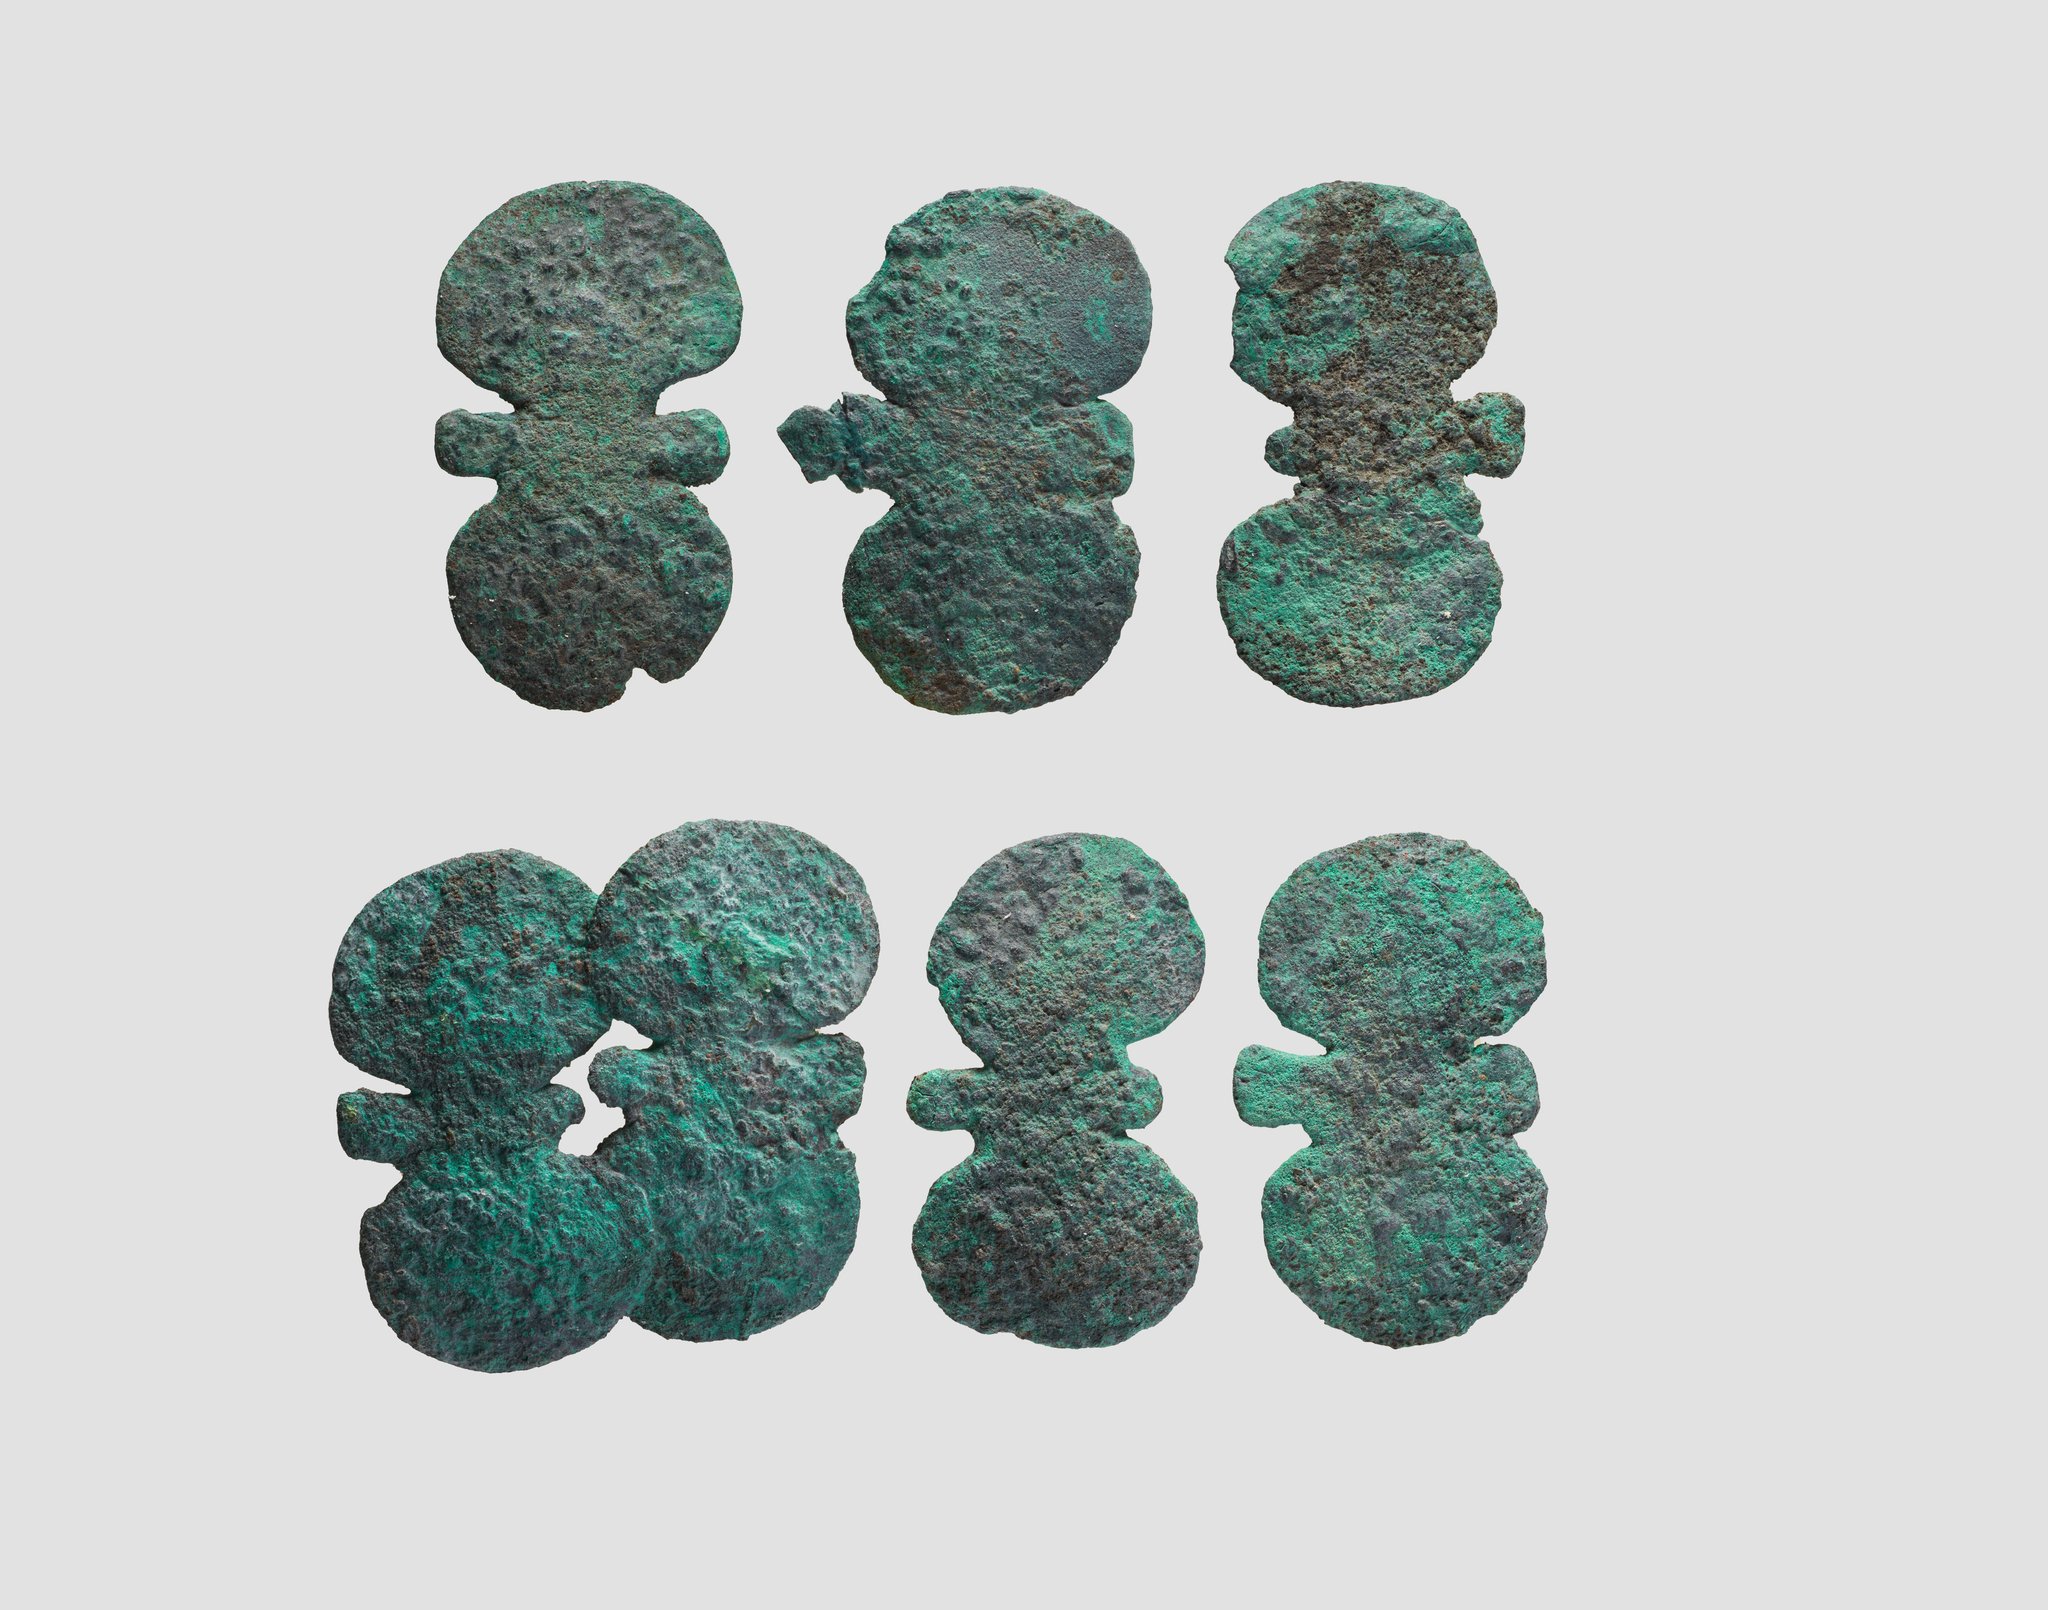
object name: harness or bridle fitting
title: Harness or bridle fittings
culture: iranian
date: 900-801 BCE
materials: bronze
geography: iran